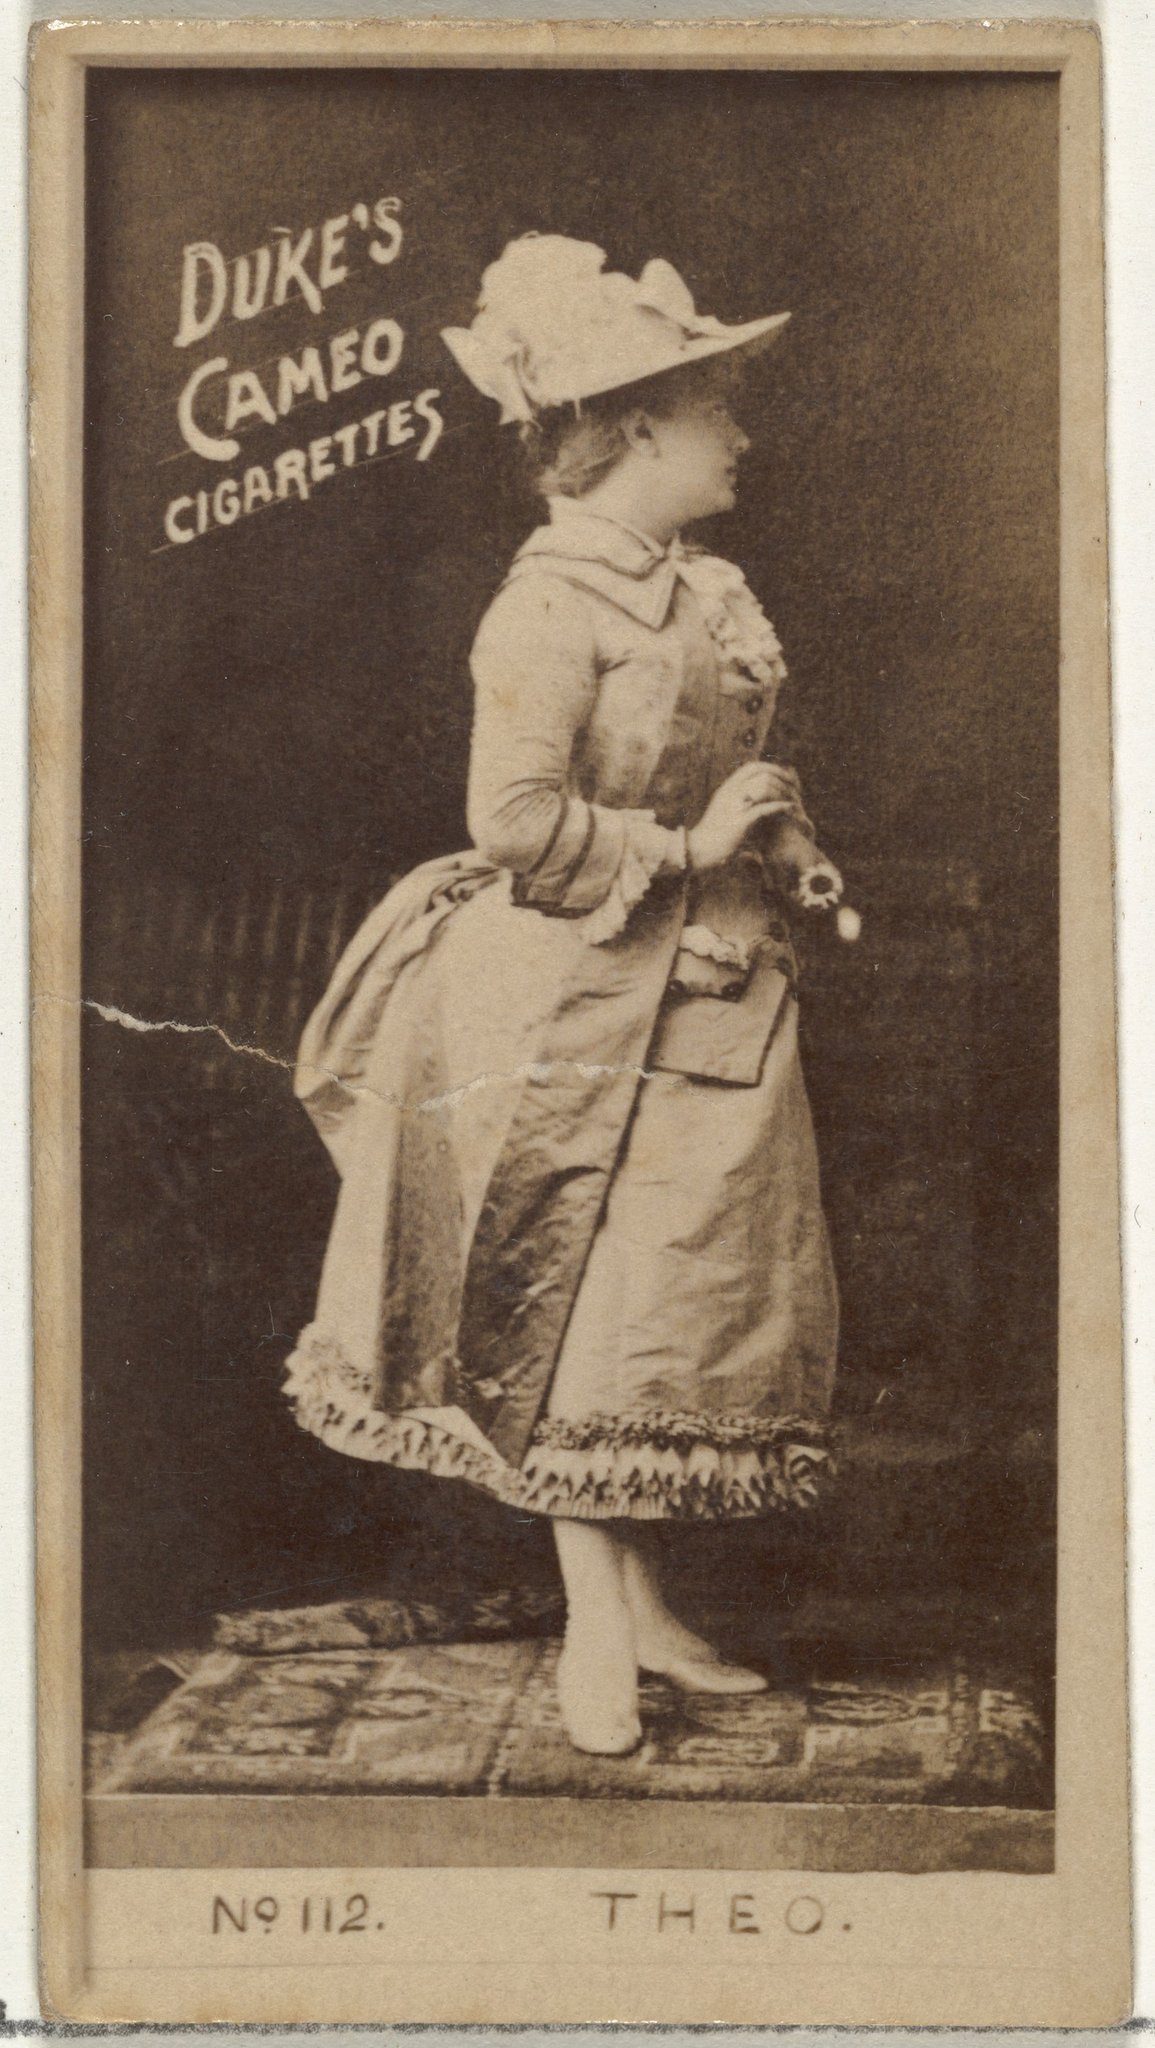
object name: photograph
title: Card Number 112, Theo, from the Actors and Actresses series (N145-4) issued by Duke Sons & Co. to promote Cameo Cigarettes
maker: w. duke, sons & co.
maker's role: publisher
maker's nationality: american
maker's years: 1870-1920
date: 1880-1889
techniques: albumen silver print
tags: women,actresses